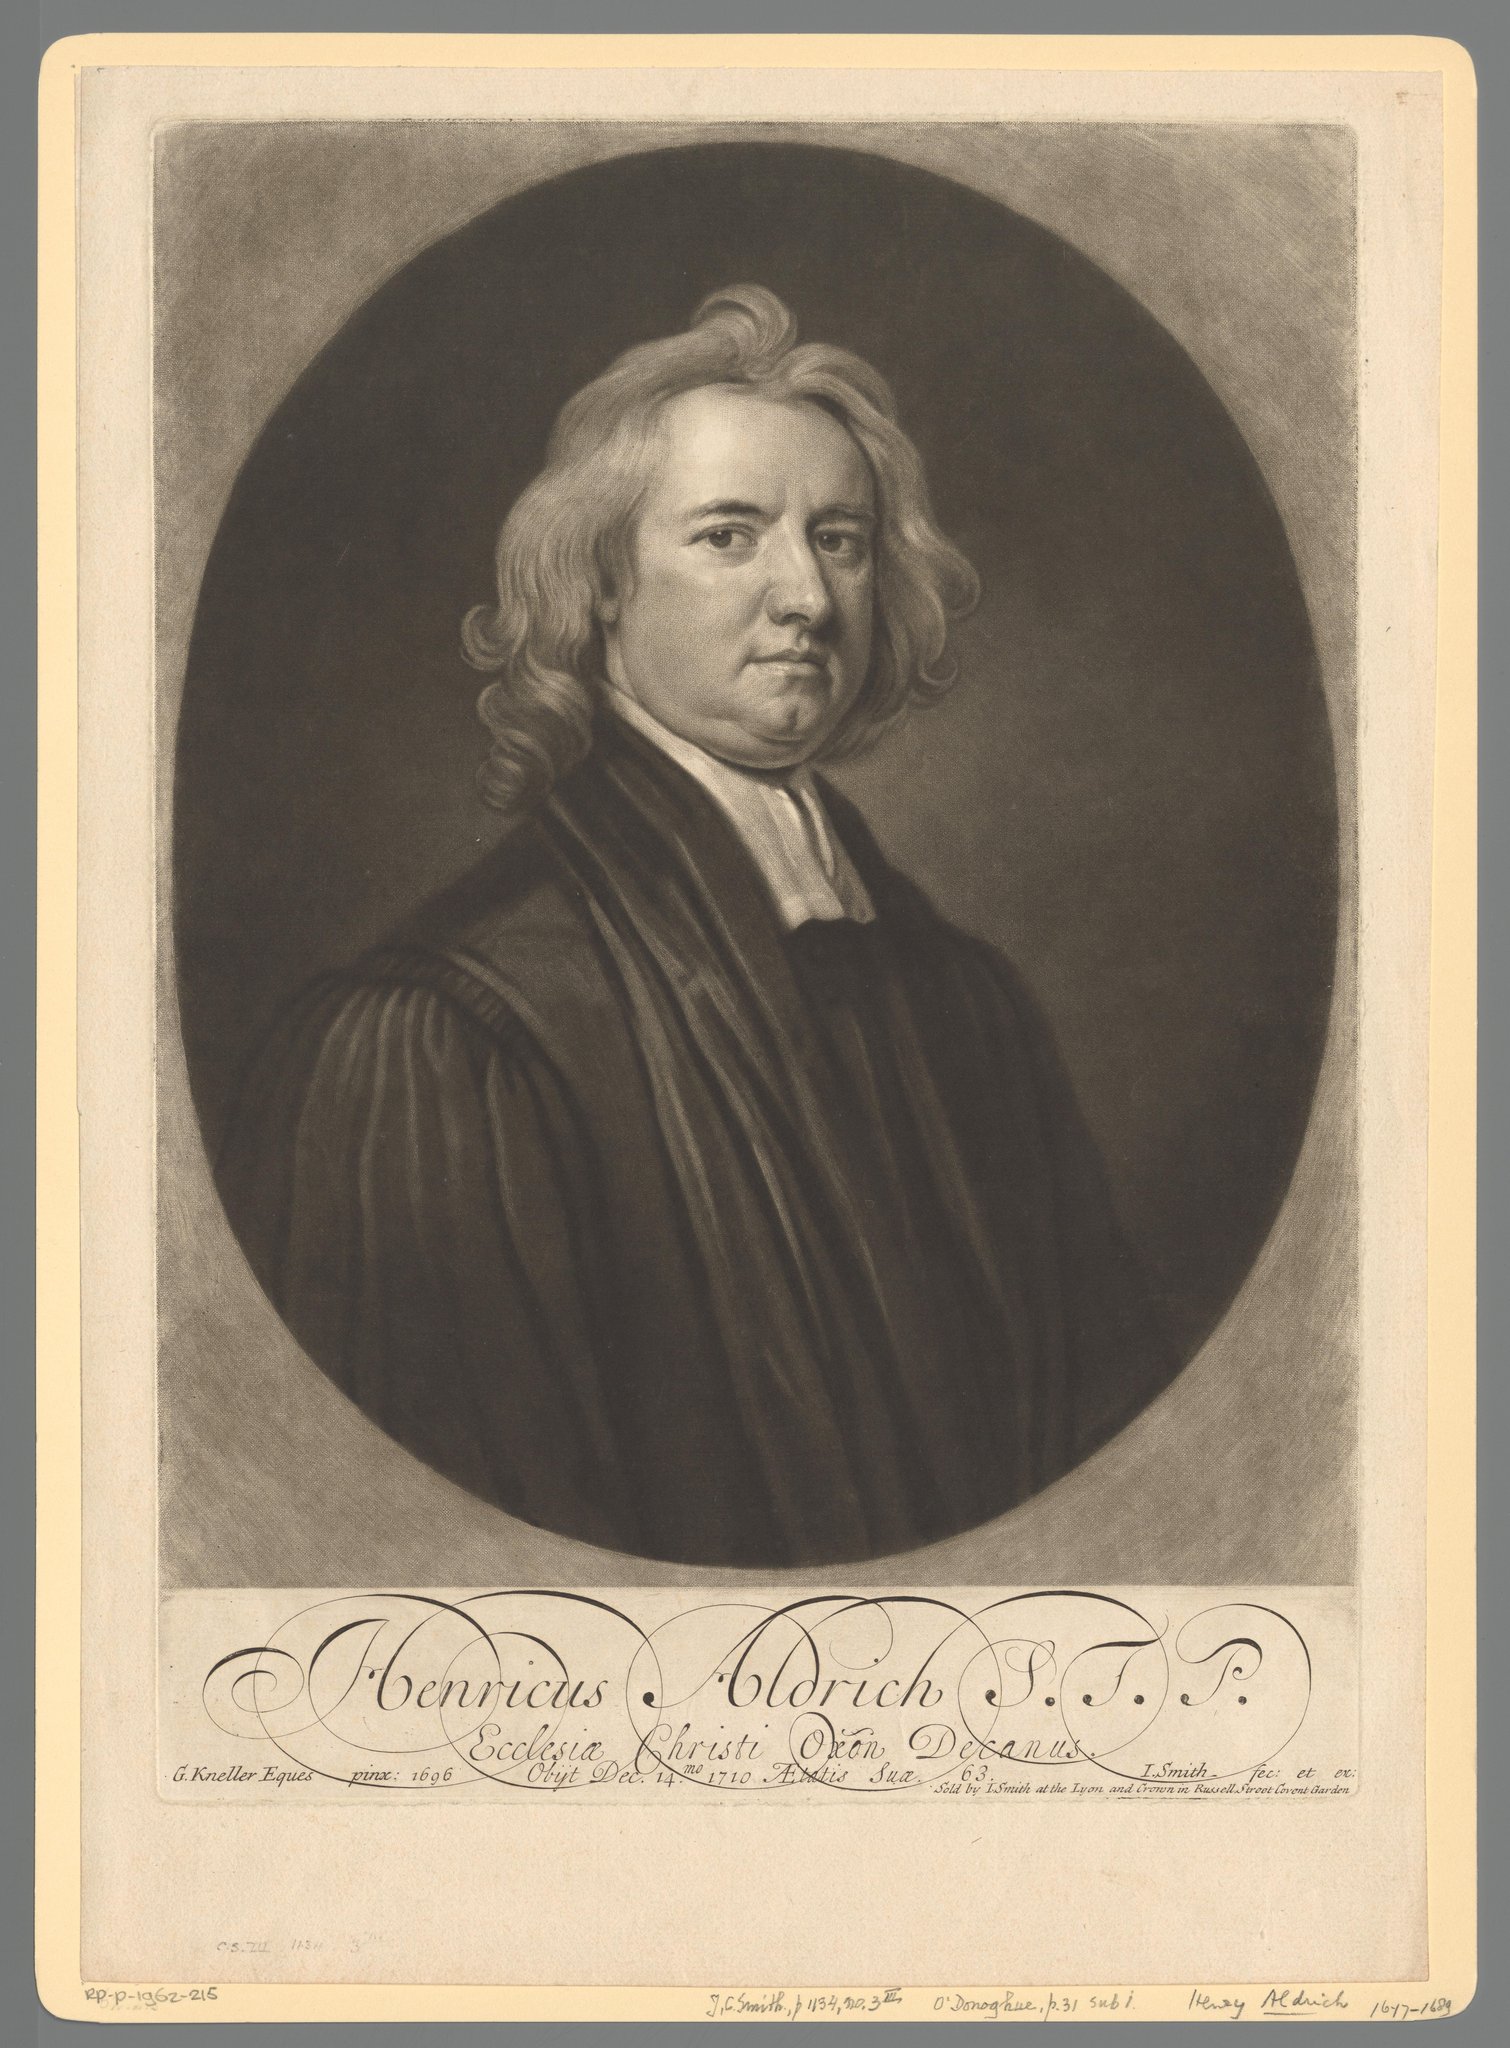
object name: print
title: Portret van Henry Aldrich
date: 1710-1743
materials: paper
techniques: mezzotint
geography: england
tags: componist, theoloog, henry aldrich